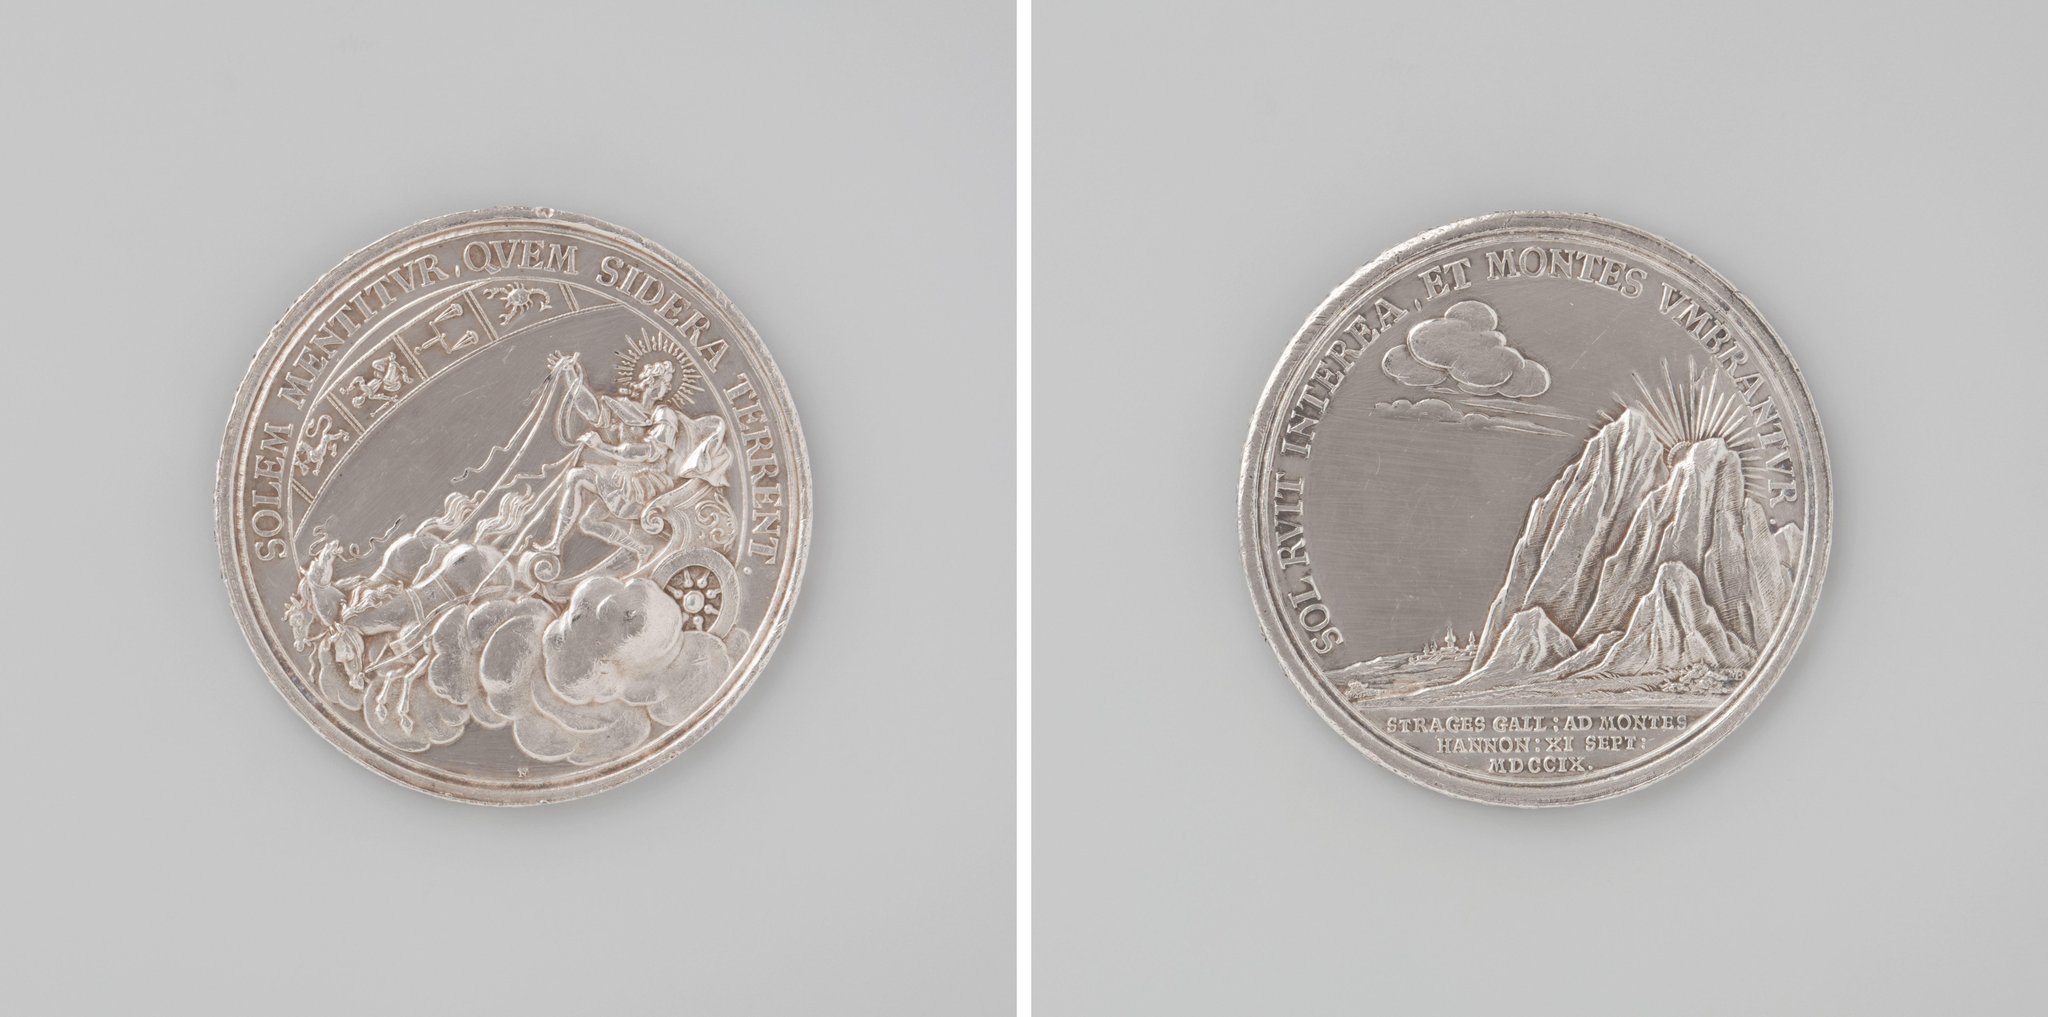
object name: history medal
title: Slag bij Malplaquet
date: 1709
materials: silver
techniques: striking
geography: nuremberg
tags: nord, malplaquet, slag bij malplaquet (1709)